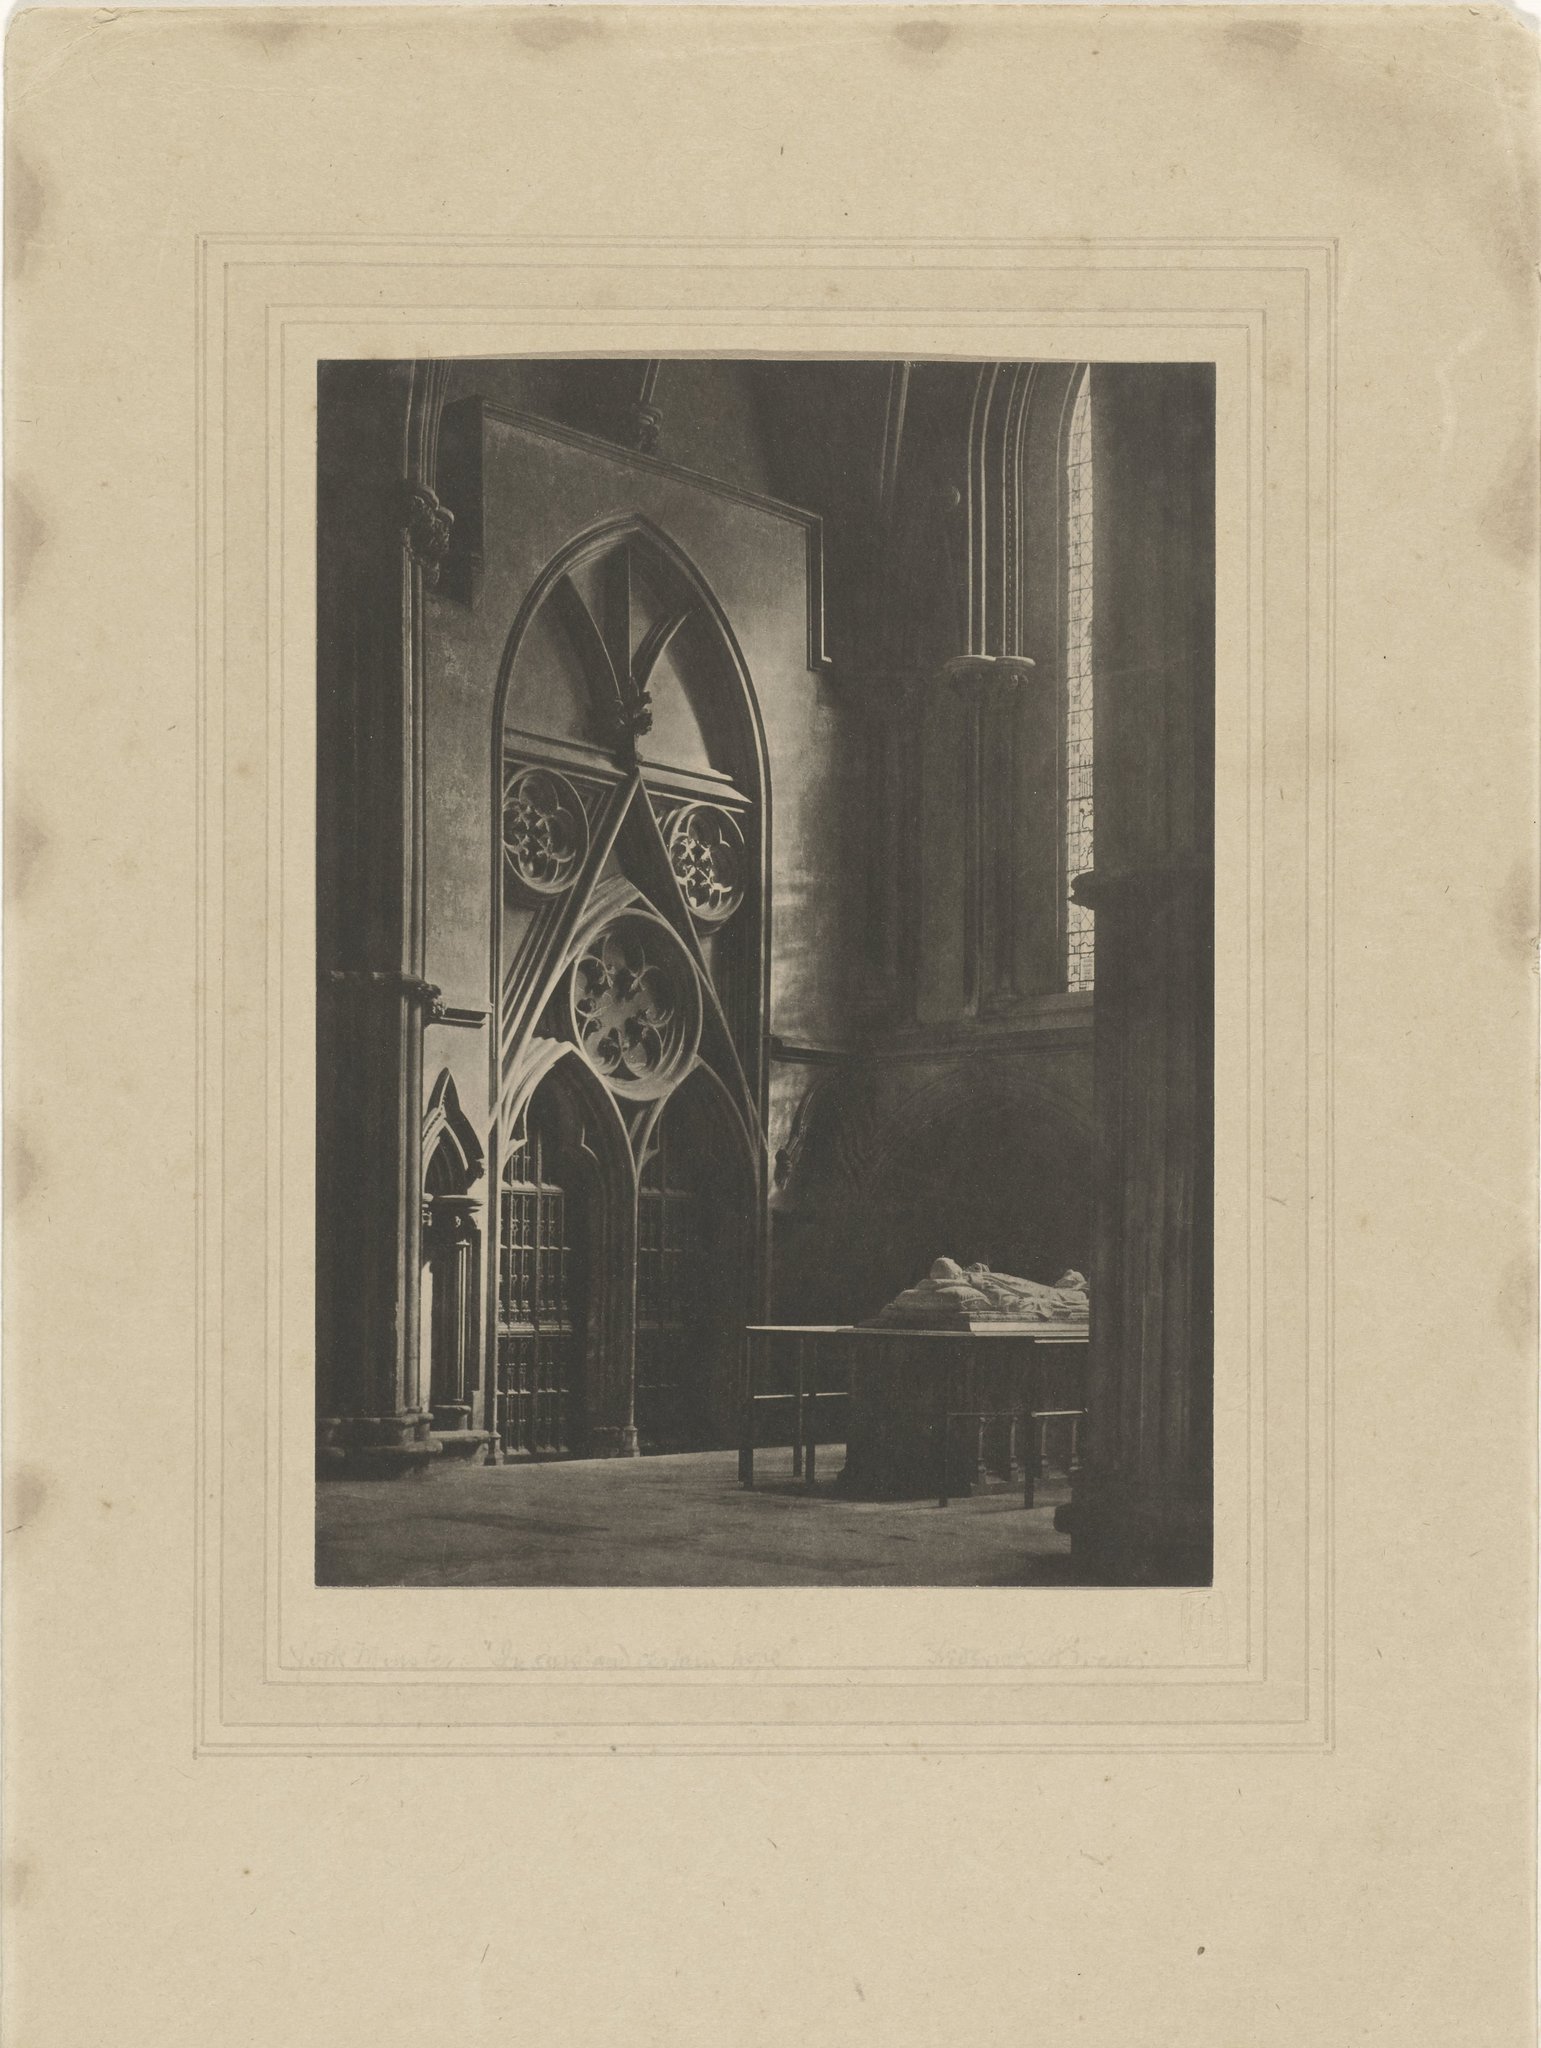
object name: photomechanical print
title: Interieur van de kathedraal van York, de York Minster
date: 1898-1903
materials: cardboard, paper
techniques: photoaquatint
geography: york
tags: interior of church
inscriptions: initials: ‘FHE’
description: Gezicht in een zijkapel met een grafsculptuur.